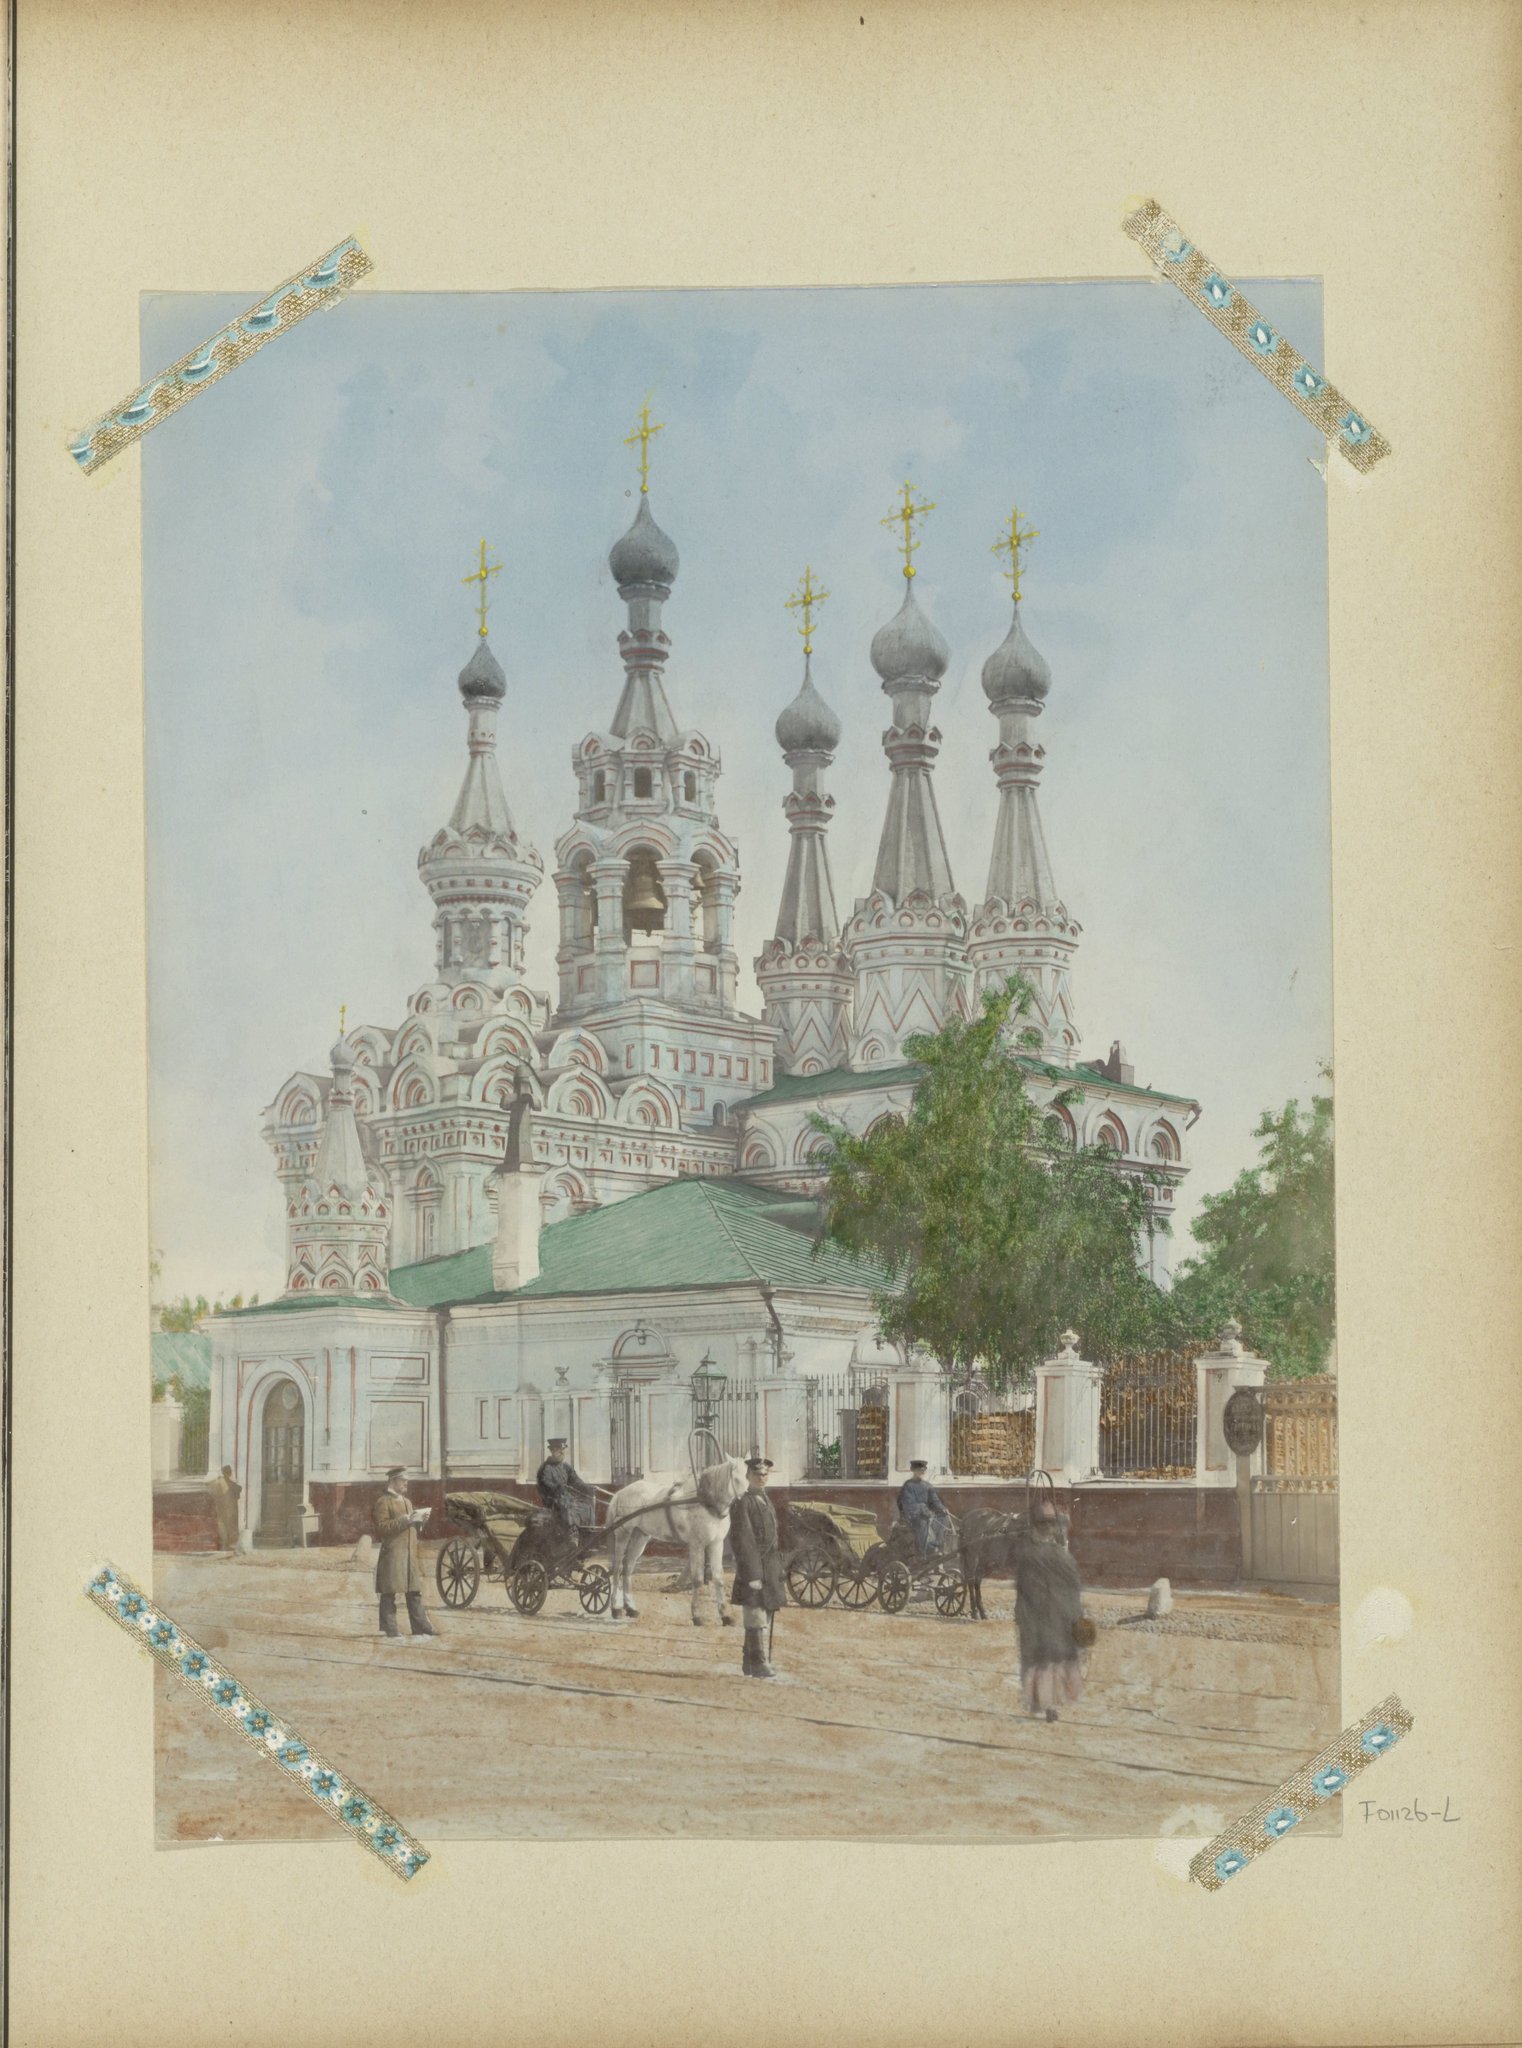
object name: photograph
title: Exterieur van de Geboortekerk van de Maagd Maria in Poutinki te Moskou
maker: b. avanzo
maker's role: fotograaf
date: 1890-1900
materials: paint, photographic support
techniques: albumen print, hand coloring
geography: moscow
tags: four-wheeled, animal-drawn vehicle, e.g.: cab, carriage, coach, church (exterior)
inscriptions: inscription: ‘Moscou. Eglise Poutinka. Church Poutinka.’, name: ‘Tableaux et Objets d'Art B. Avanzo Moscou.’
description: Onderdeel van Fotoalbum met opnames van bezienswaardigheden in Georgië, Sint-Petersburg en Moskou.